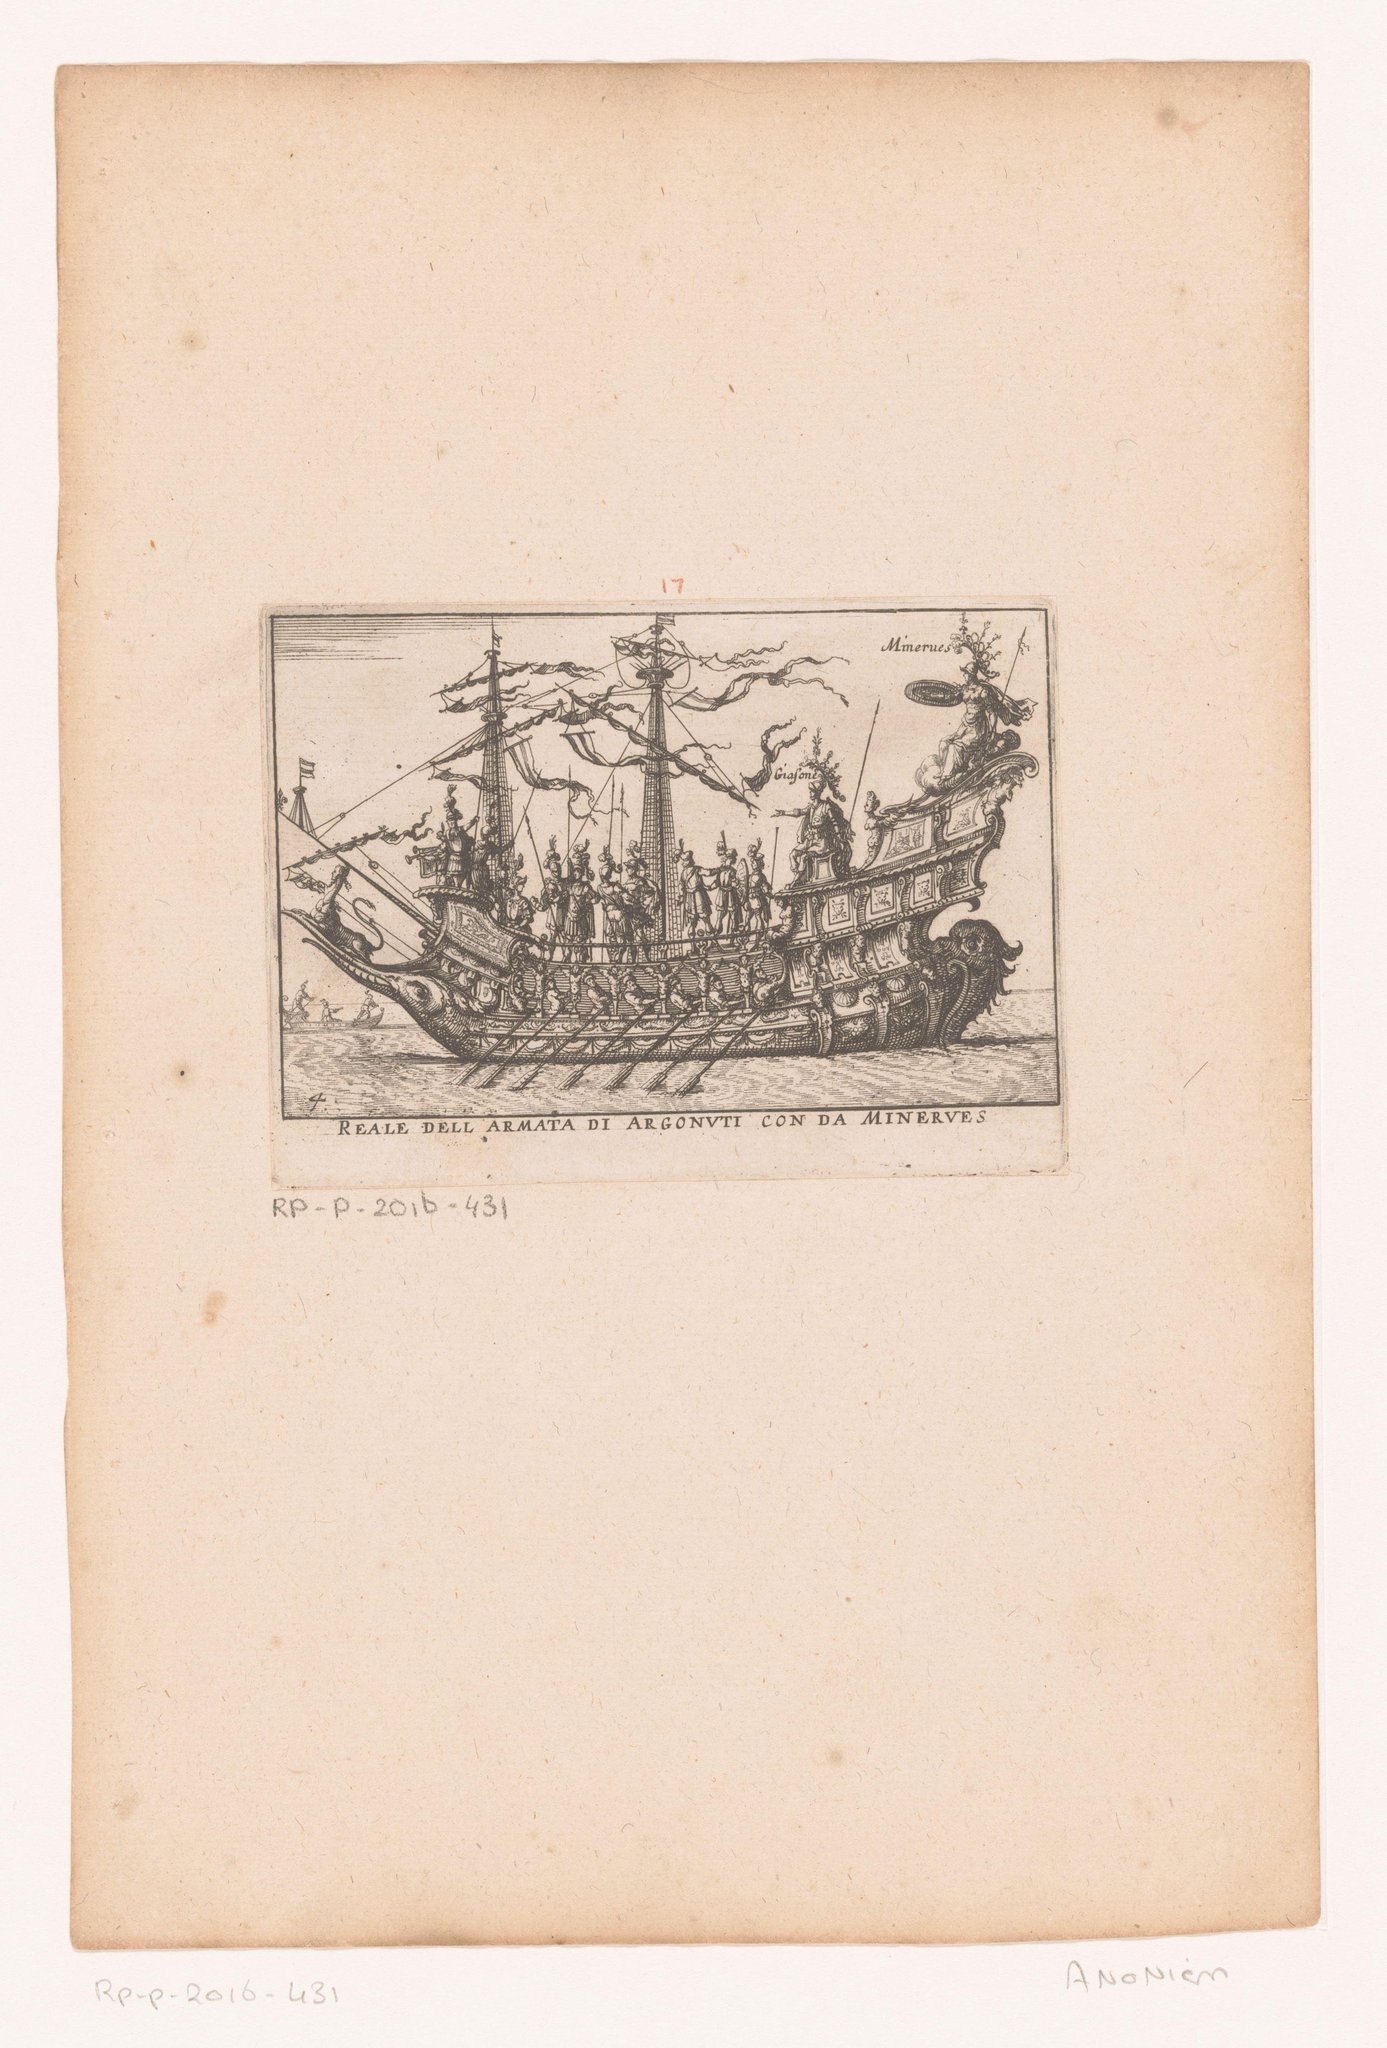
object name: print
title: Schip met Jason en Minerva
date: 1624-1631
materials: paper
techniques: etching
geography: paris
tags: (story of) minerva (pallas, athena), (story of) jason, ships (in general), the story of the argonauts: the quest for the golden fleece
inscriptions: number: ‘17’, collector's mark: Lugt 2228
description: Een schip met sfinx als boegbeeld, Argonauten op het middenschip en op het achtersteven zitten Jason en Minerva.